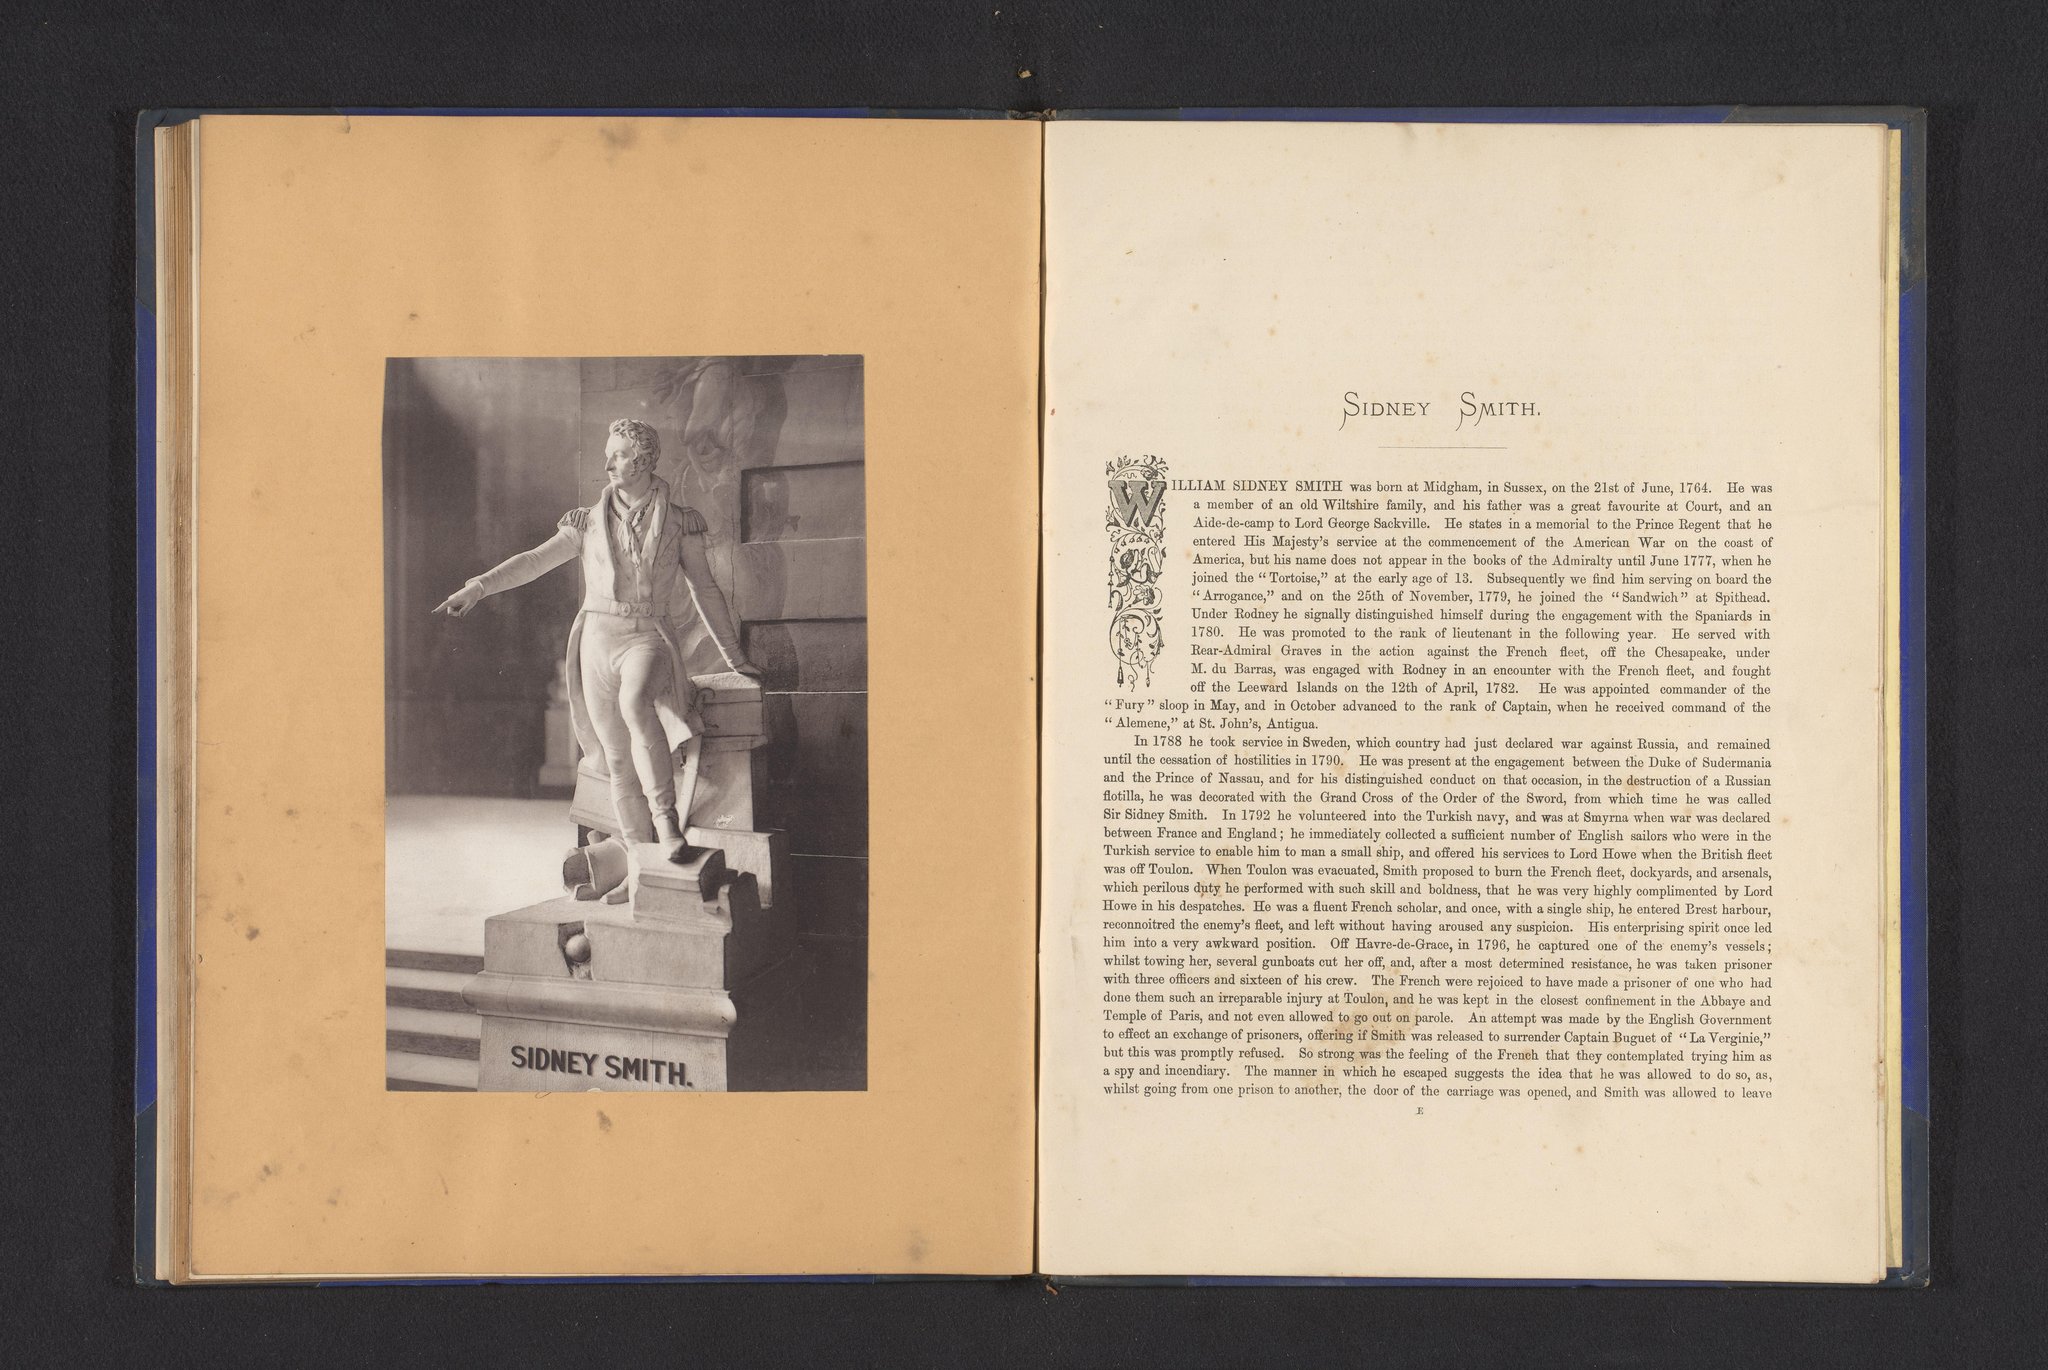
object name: page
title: Opname van het standbeeld van Sidney Smith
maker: Anonymous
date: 1876-1881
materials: paper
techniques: photograph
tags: designer, naval officer, sidney smith, historical persons, sculpture